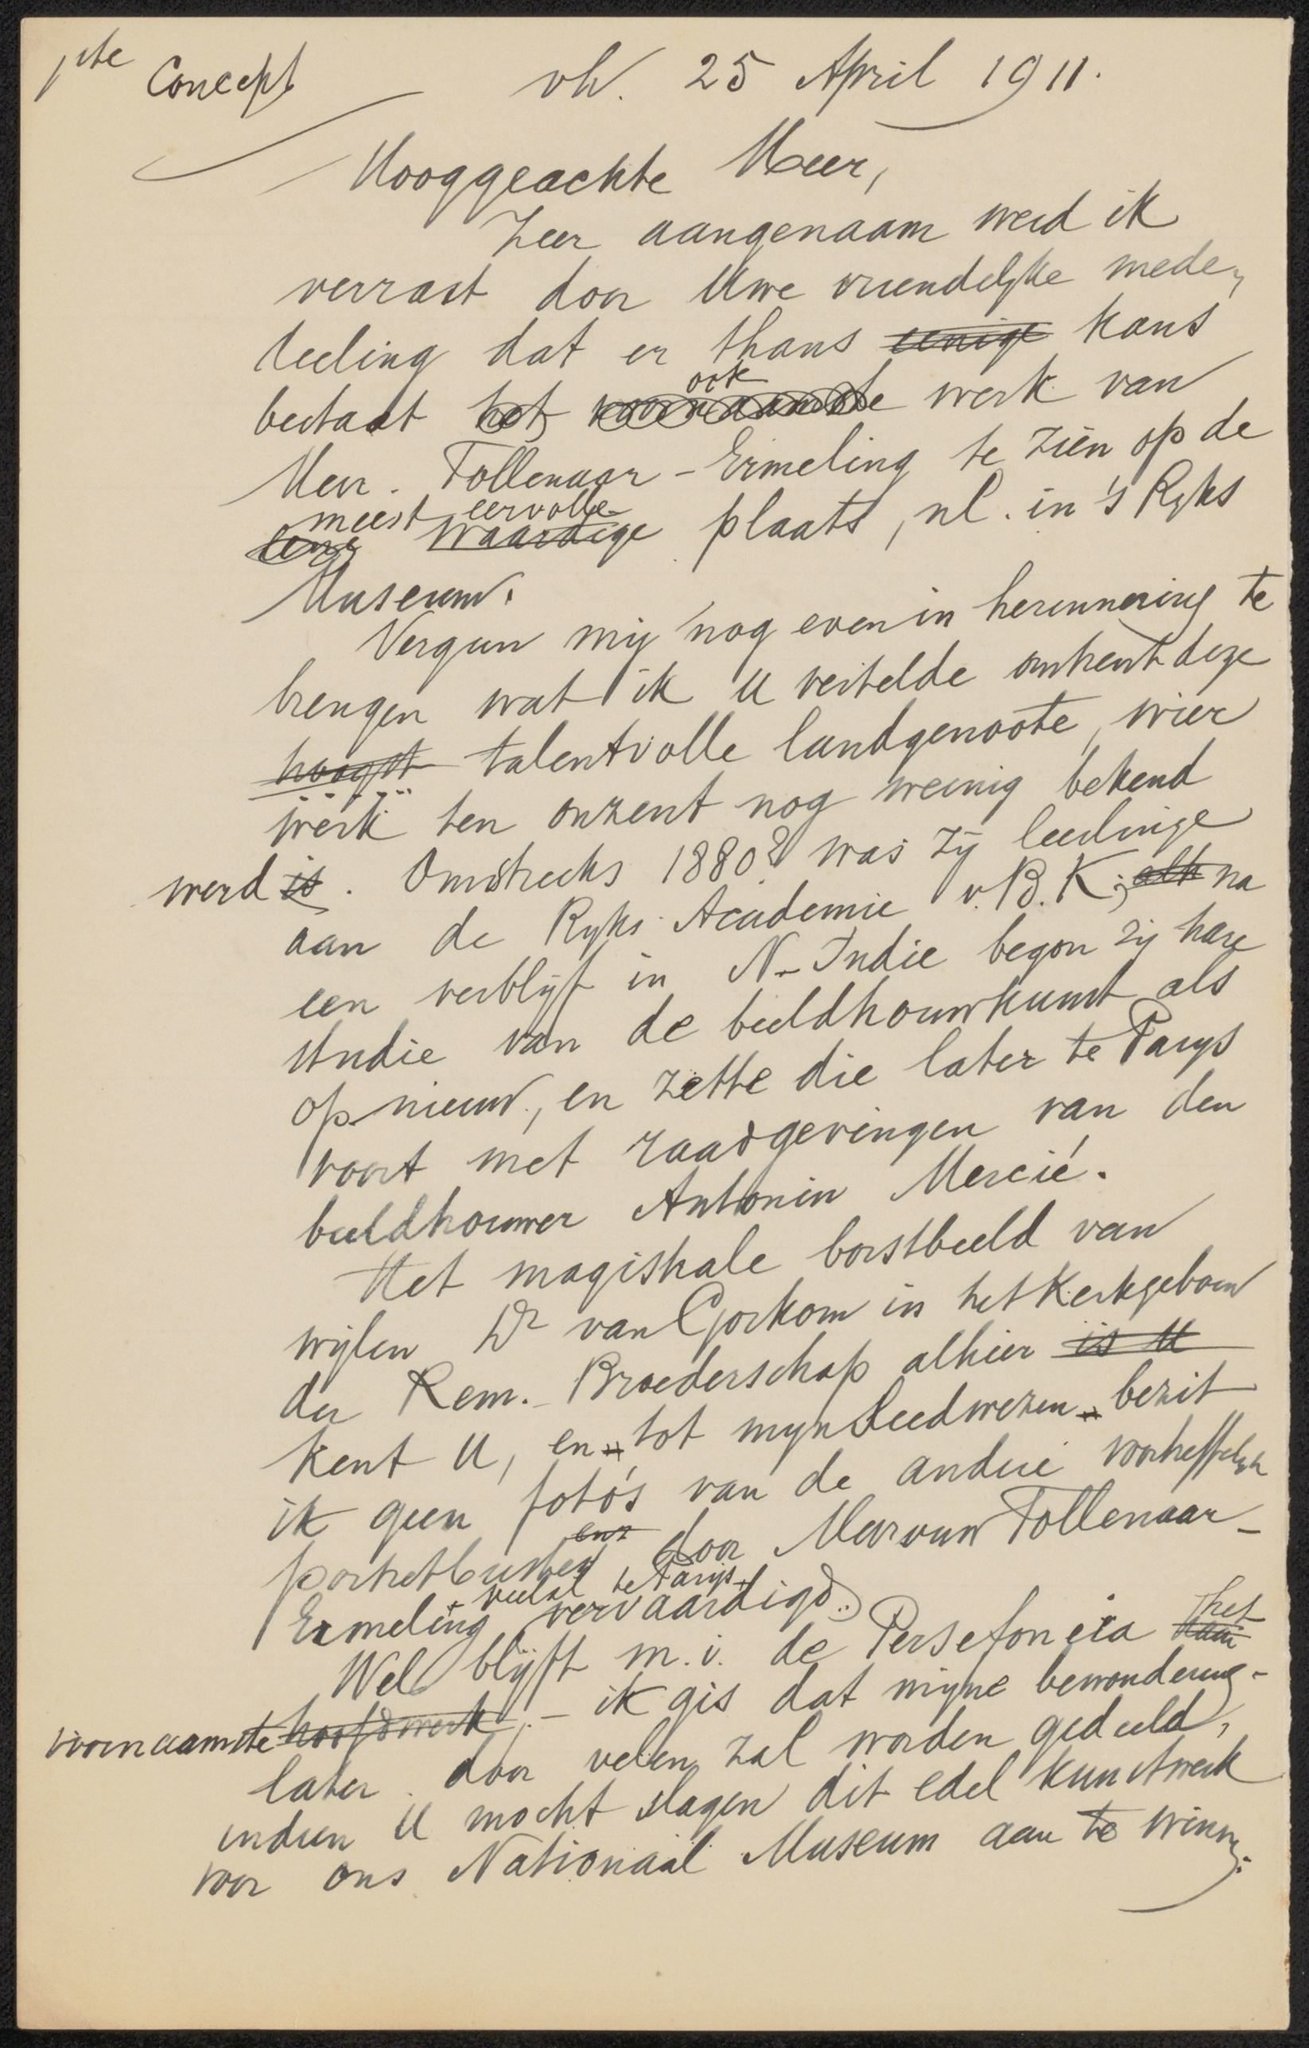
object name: letter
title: Brief aan jonkheer Barthold Willem Floris van Riemsdijk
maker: august allebé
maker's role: draughtsman, print maker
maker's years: 1838-1927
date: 1911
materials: ink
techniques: pen, writing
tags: draughtsman, annie ermeling, maastricht, amsterdam, print maker, engineer, jonkheer barthold willem floris van riemsdijk, paris, painter, sculptor, marius jean antonin mercié, rijksmuseum amsterdam, sculpture, art collecting, historical persons (portraits and scenes from the life), dutch east indies, the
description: Brief is concept voor brief BI-1950-17-520.